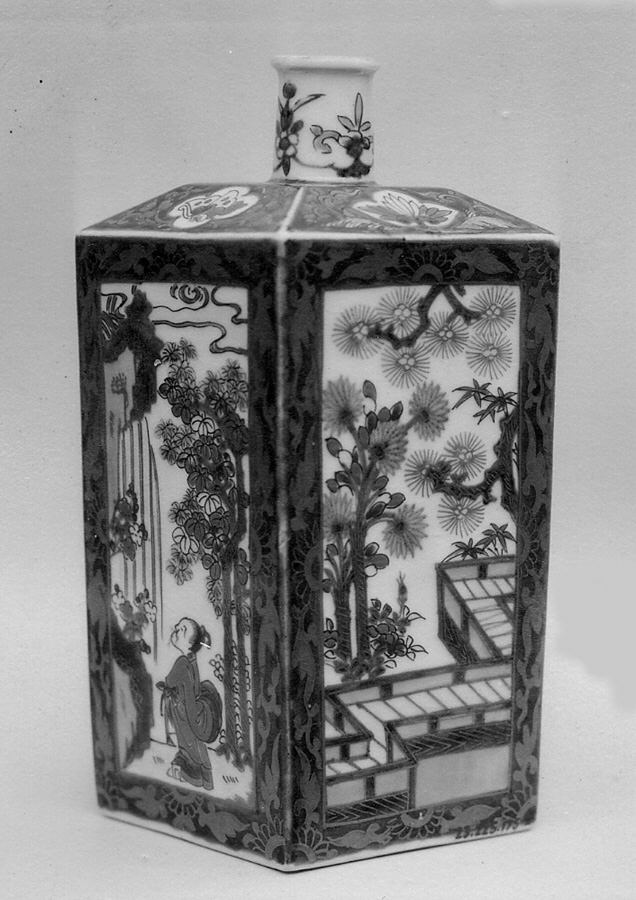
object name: wine bottle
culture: japanese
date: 1800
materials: enamel, porcelain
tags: human figures,flowers